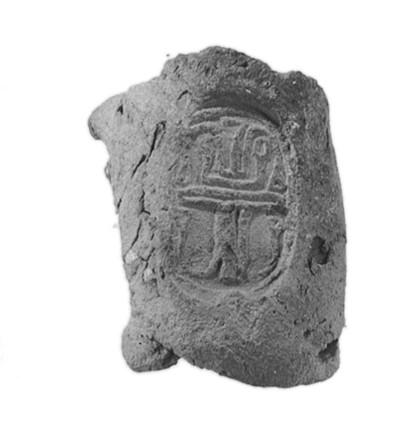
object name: sealing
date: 2030-1640 BCE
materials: clay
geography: egypt